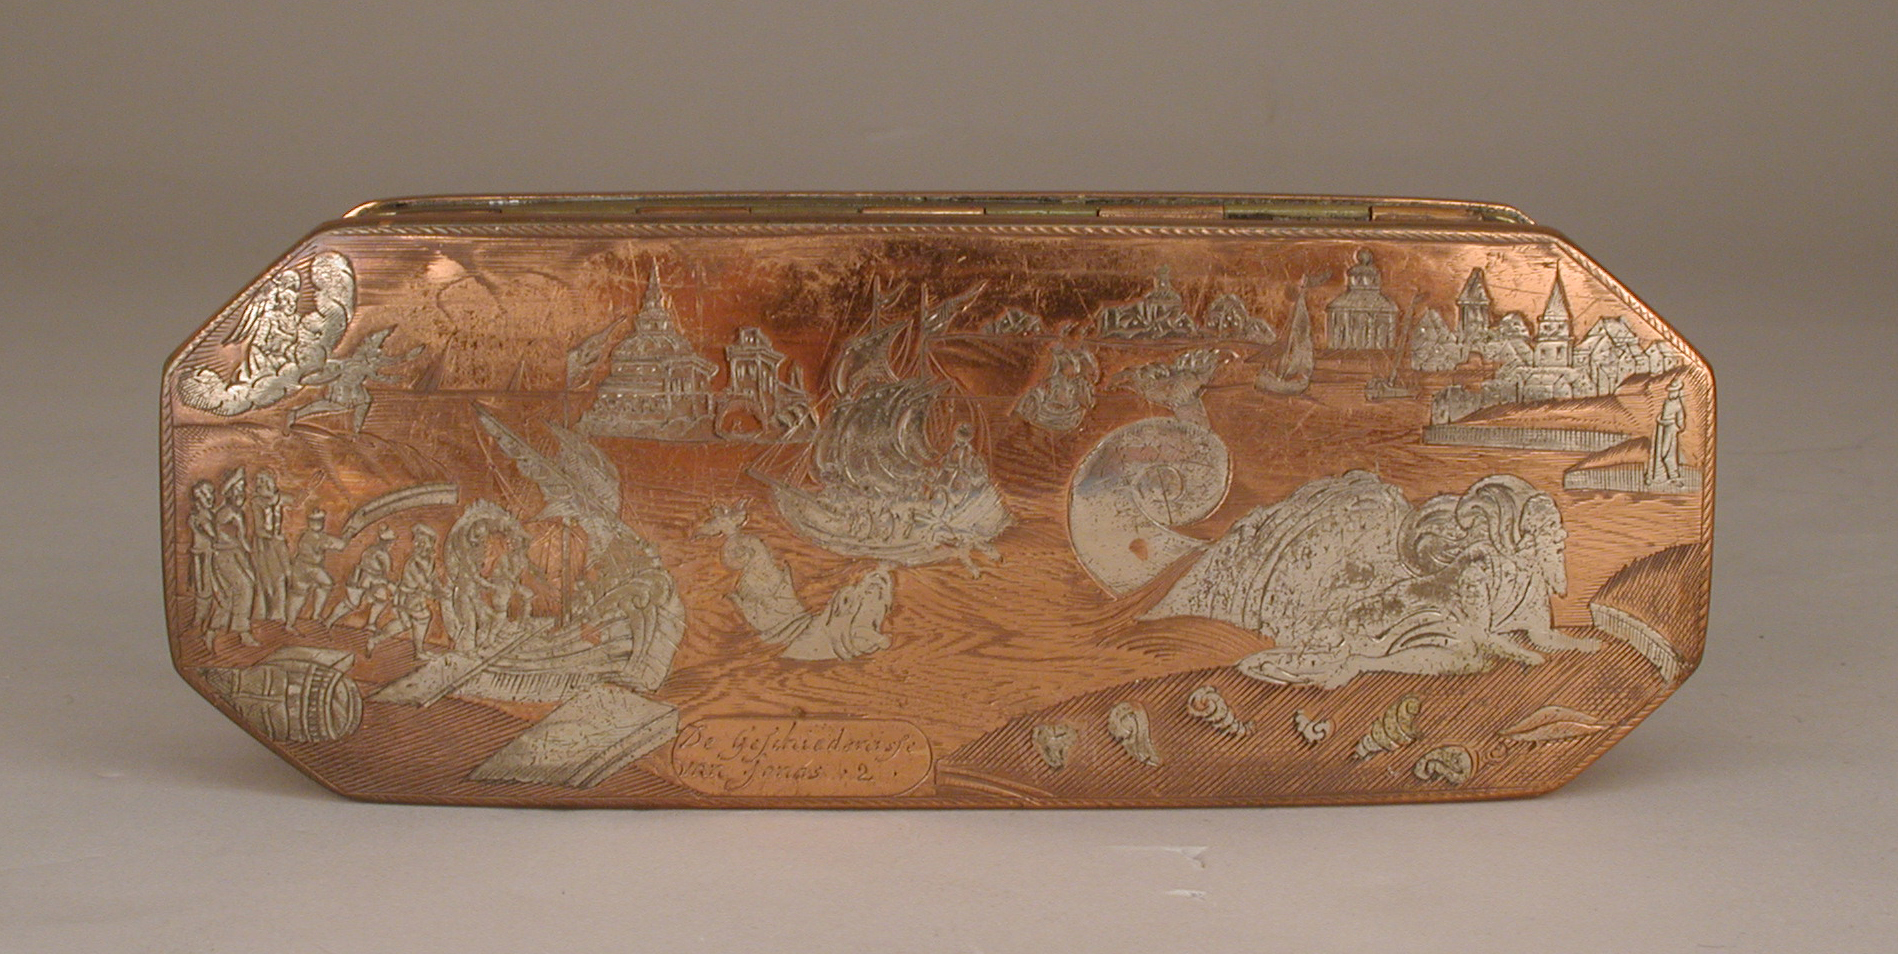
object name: tobacco box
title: Tobacco box with scenes from life of Jonah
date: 1701-1800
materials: brass, copper, silver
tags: men,apostles,ships